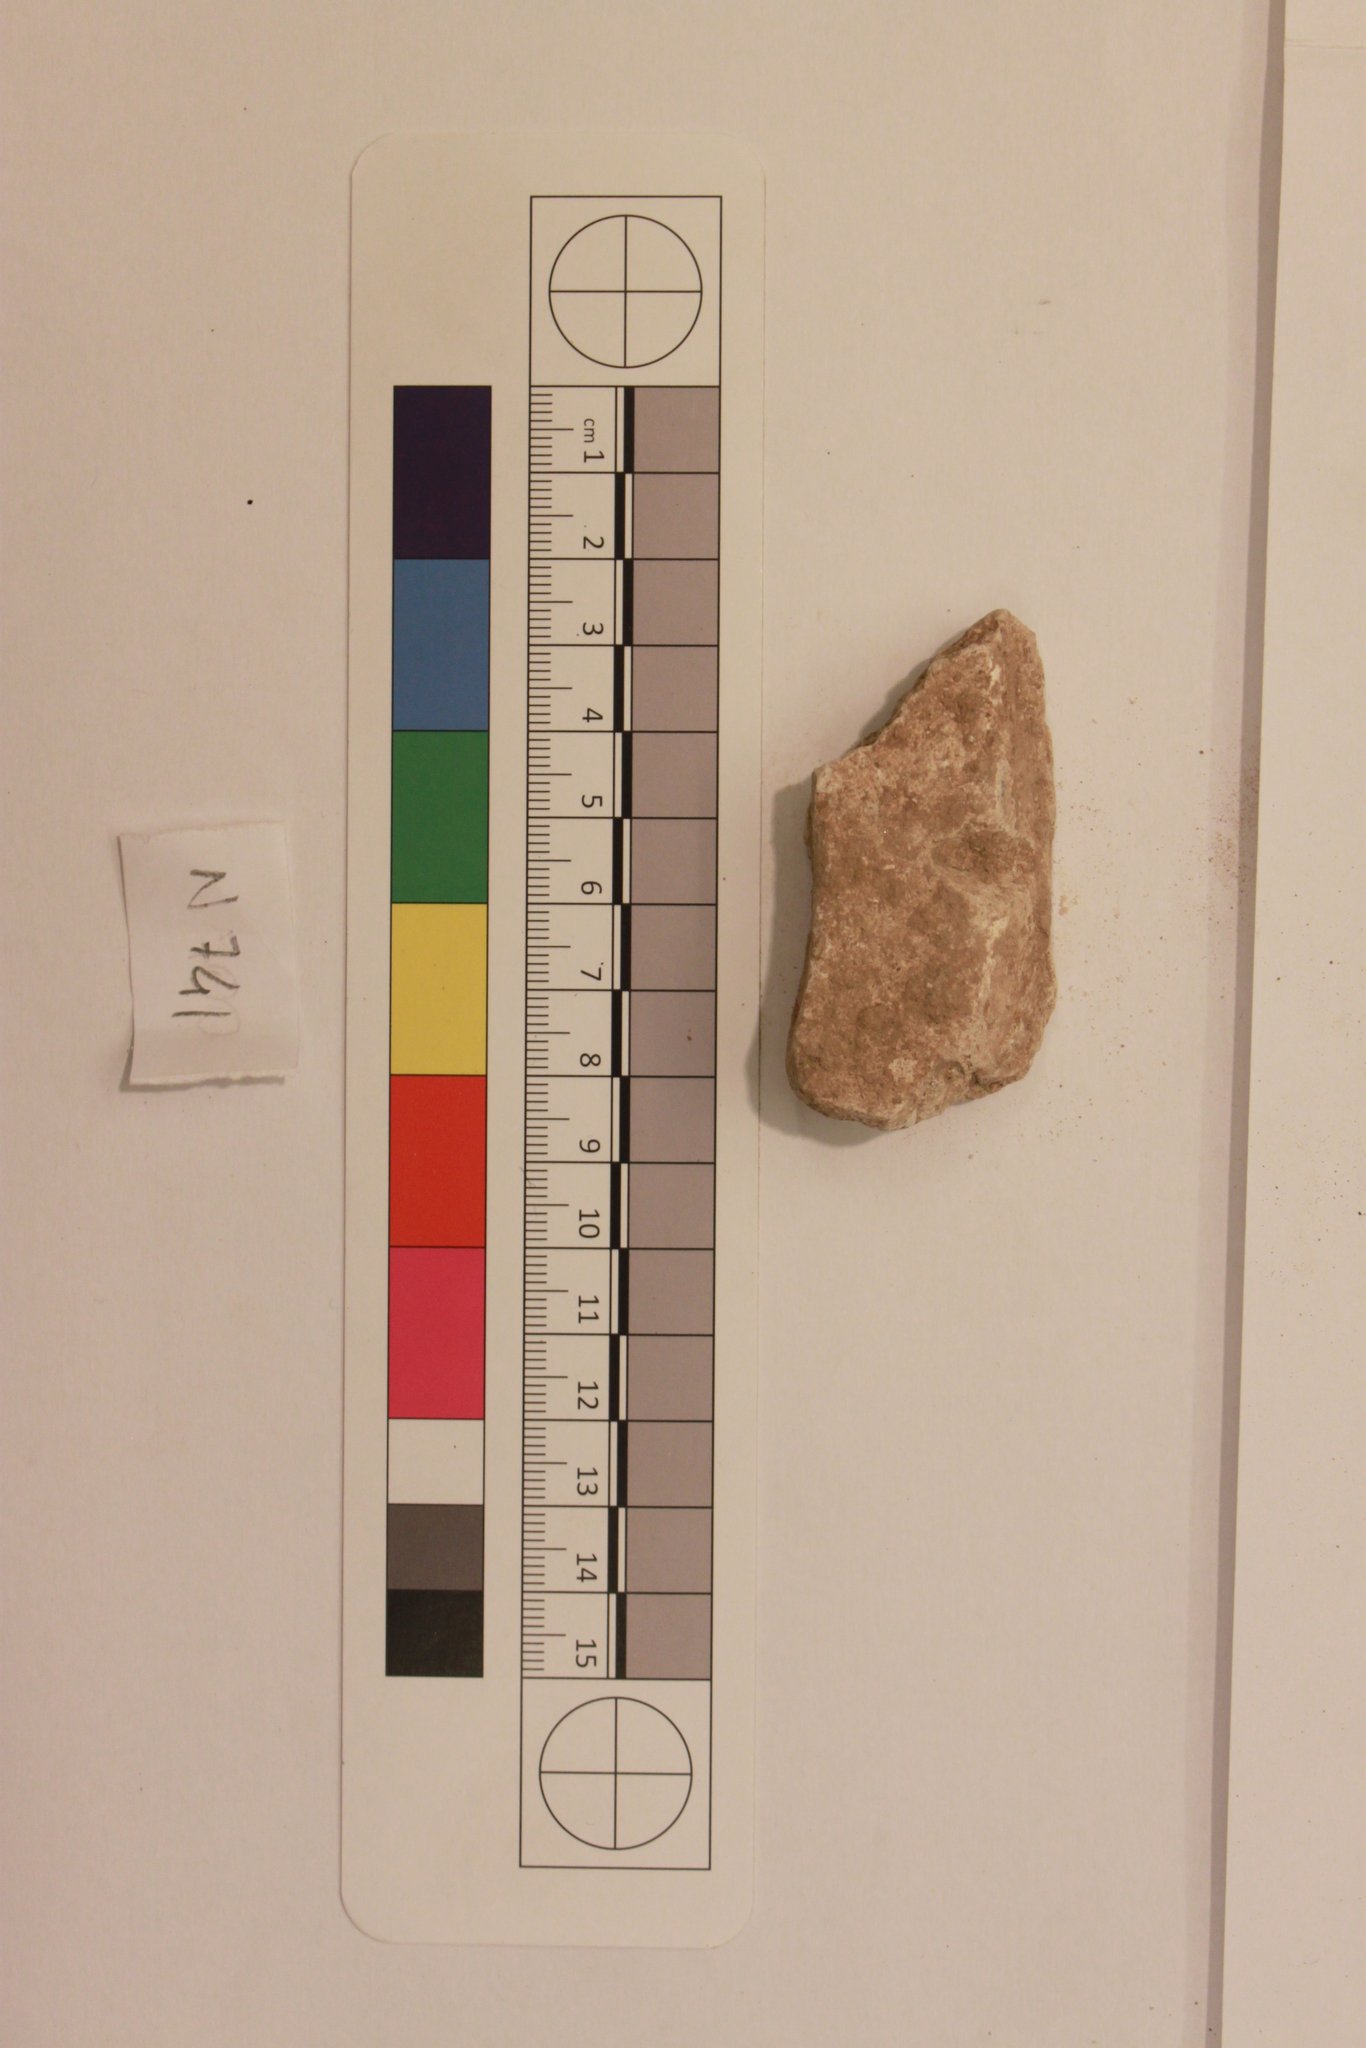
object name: fragment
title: Stucco Fragment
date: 701-1200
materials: plaster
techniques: carving, painting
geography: iran